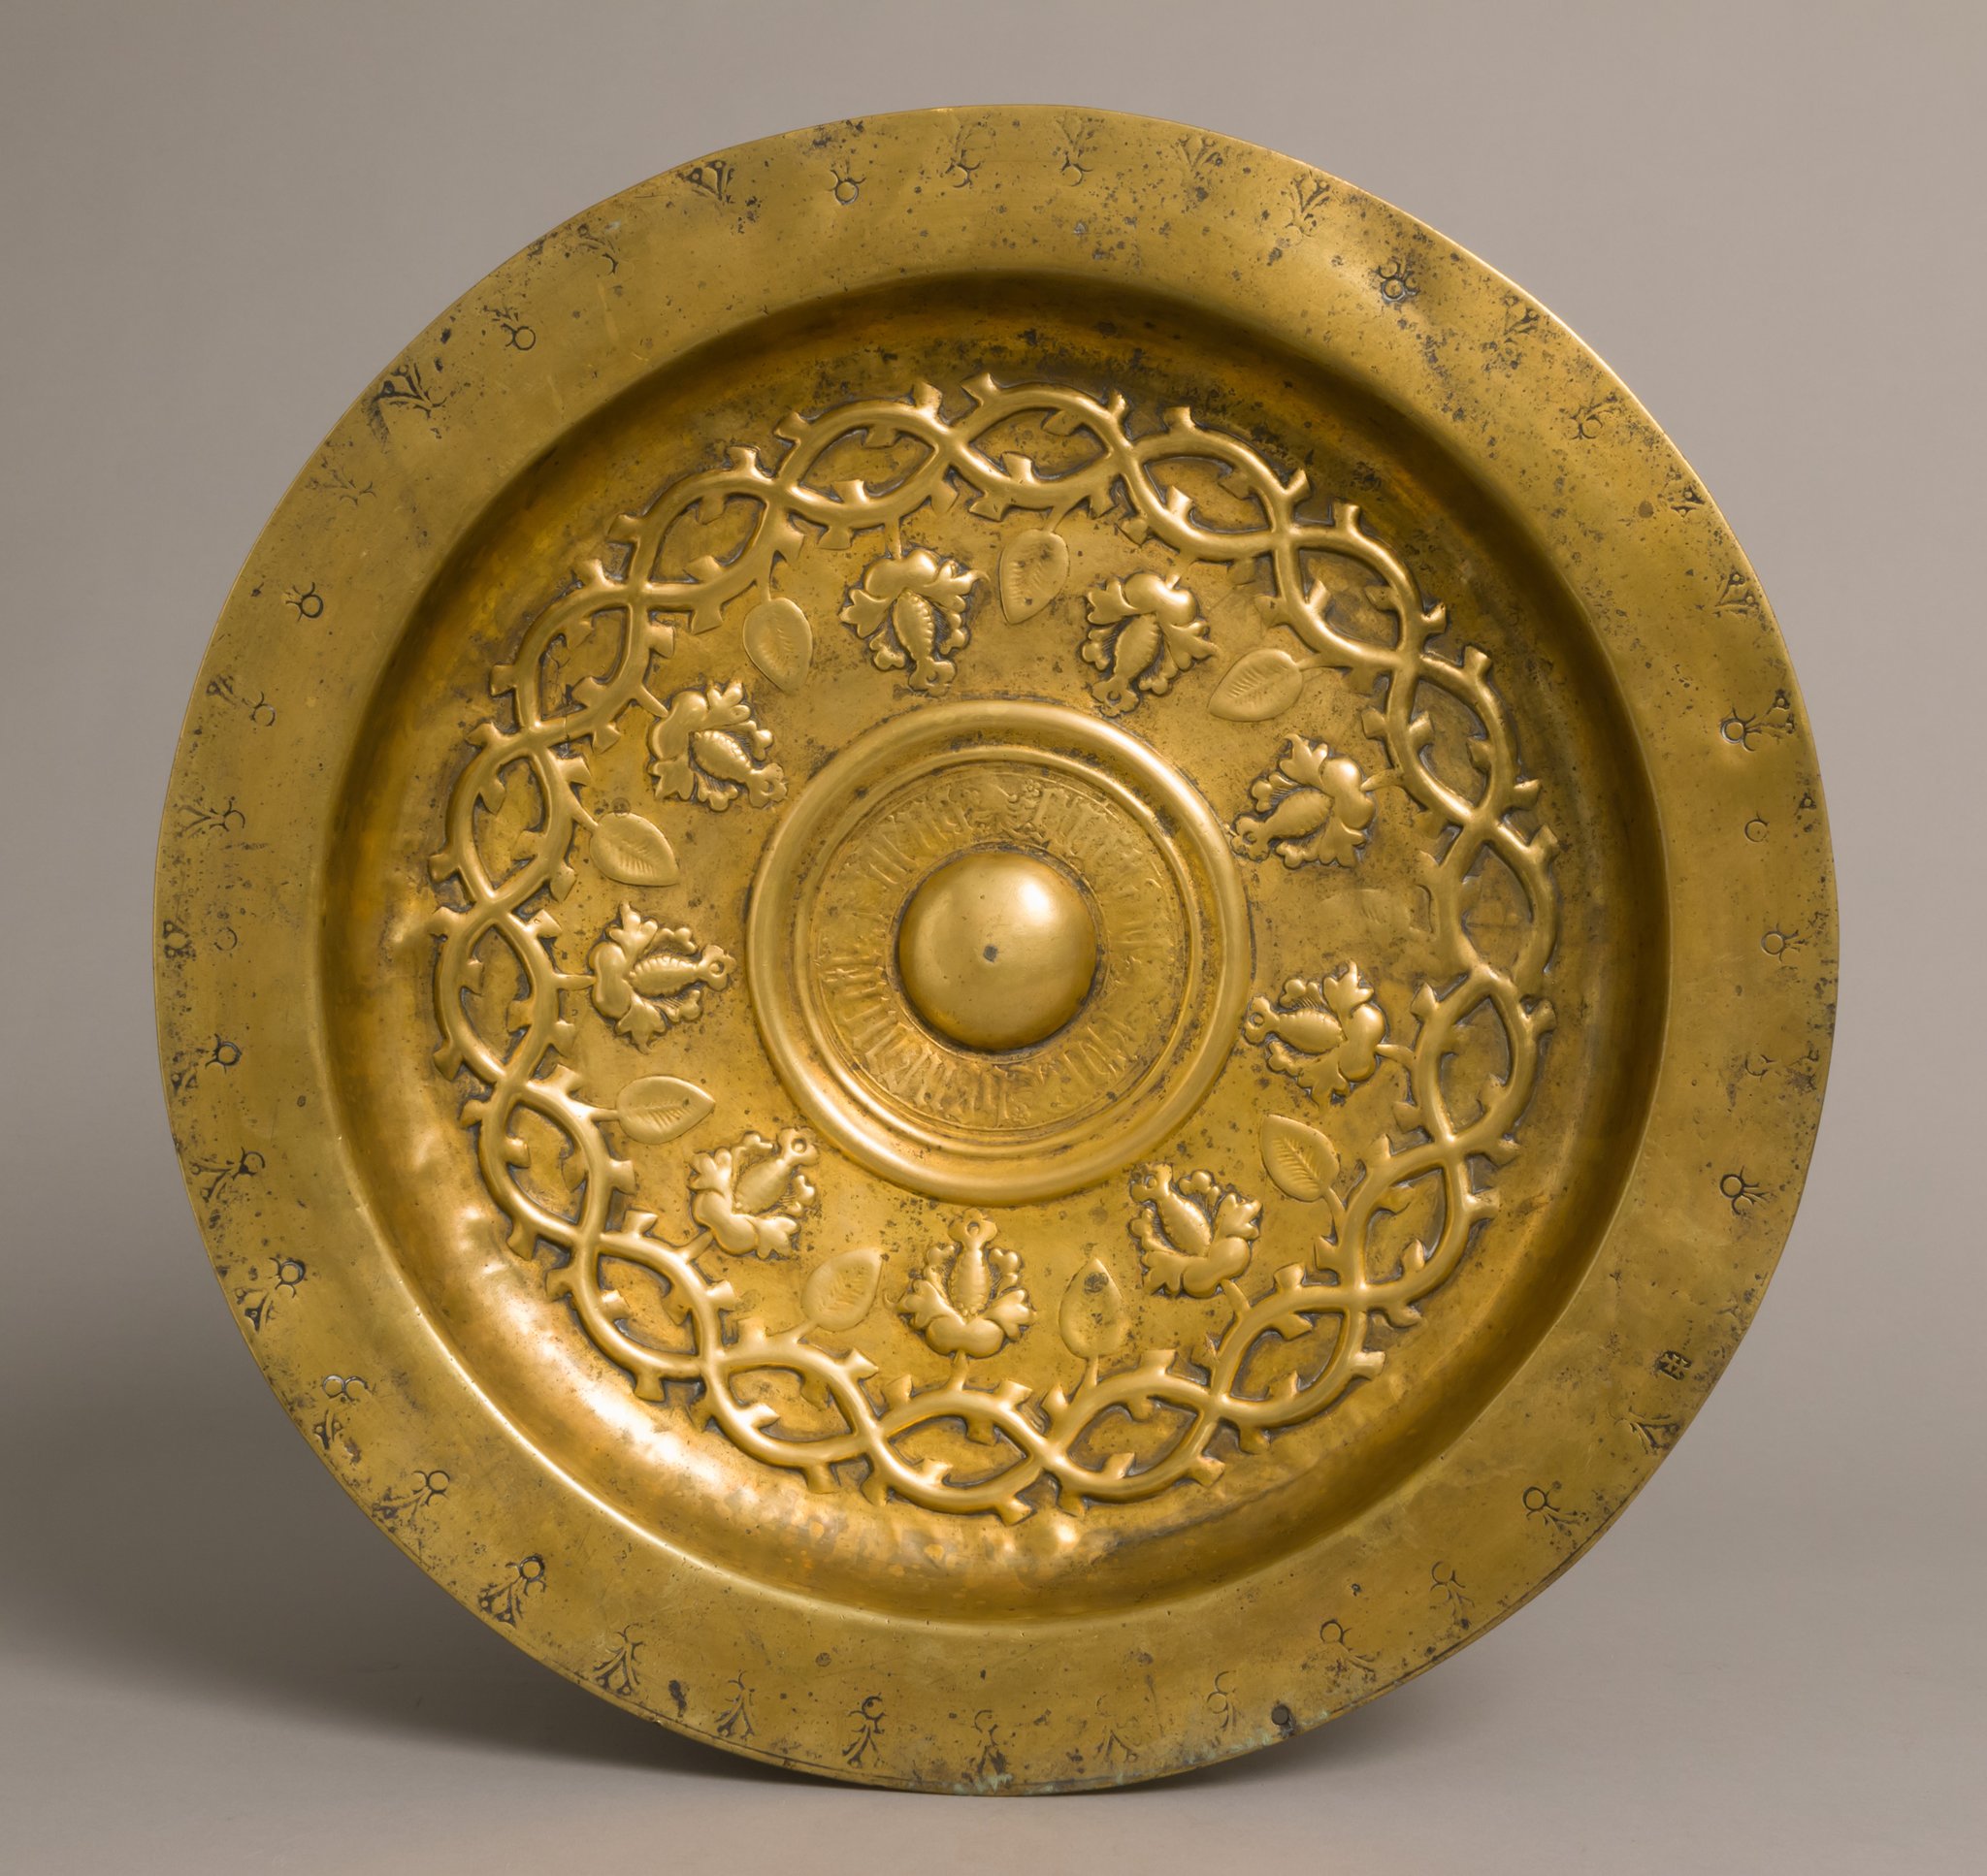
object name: plate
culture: german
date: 1467-1500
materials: brass